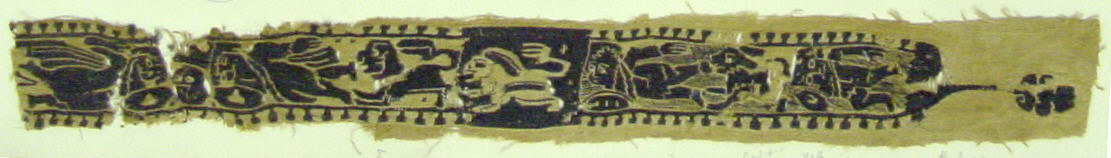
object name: textile fragment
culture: coptic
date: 501-600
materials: linen, wool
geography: egypt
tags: human figures,lions